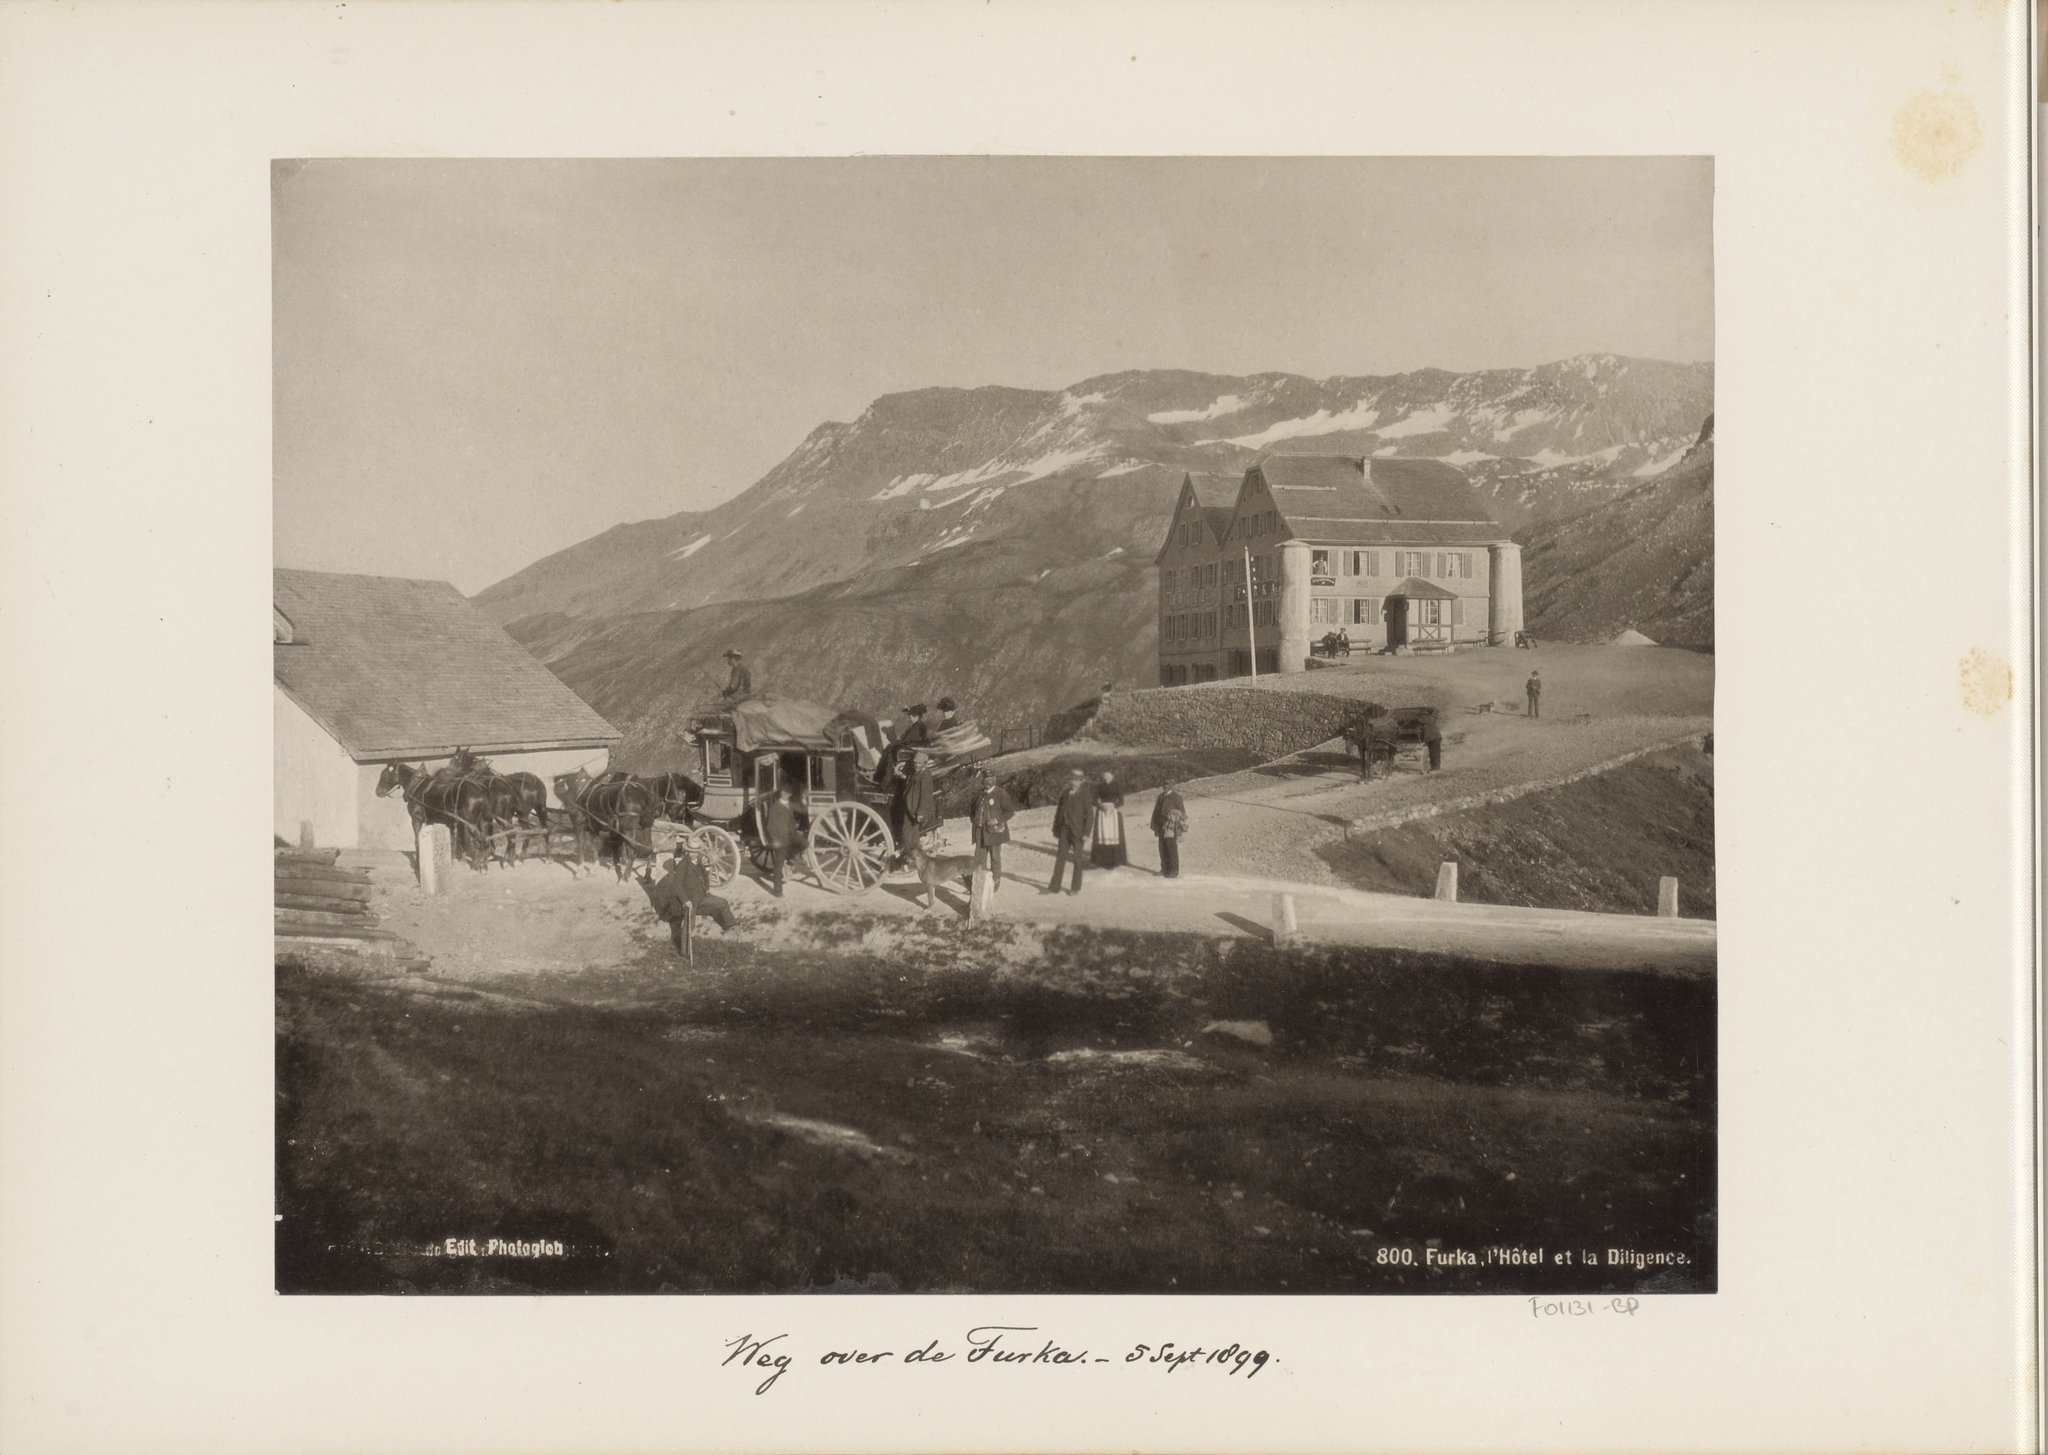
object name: photograph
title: Reizigers en paardenkoets bij Hotel Furka aan de Furkapas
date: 1880-1899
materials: paper, photographic support, ink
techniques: photograph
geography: switzerland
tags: four-wheeled, animal-drawn vehicle, e.g.: cab, carriage, coach, mountains (+ landscape with figures, staffage), hotel, hostelry, inn, switzerland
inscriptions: number: ‘800’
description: Onderdeel van Reisalbum met bezienswaardigheden in Duitsland, Oostenrijk, Zwitserland, Luxemburg en België.